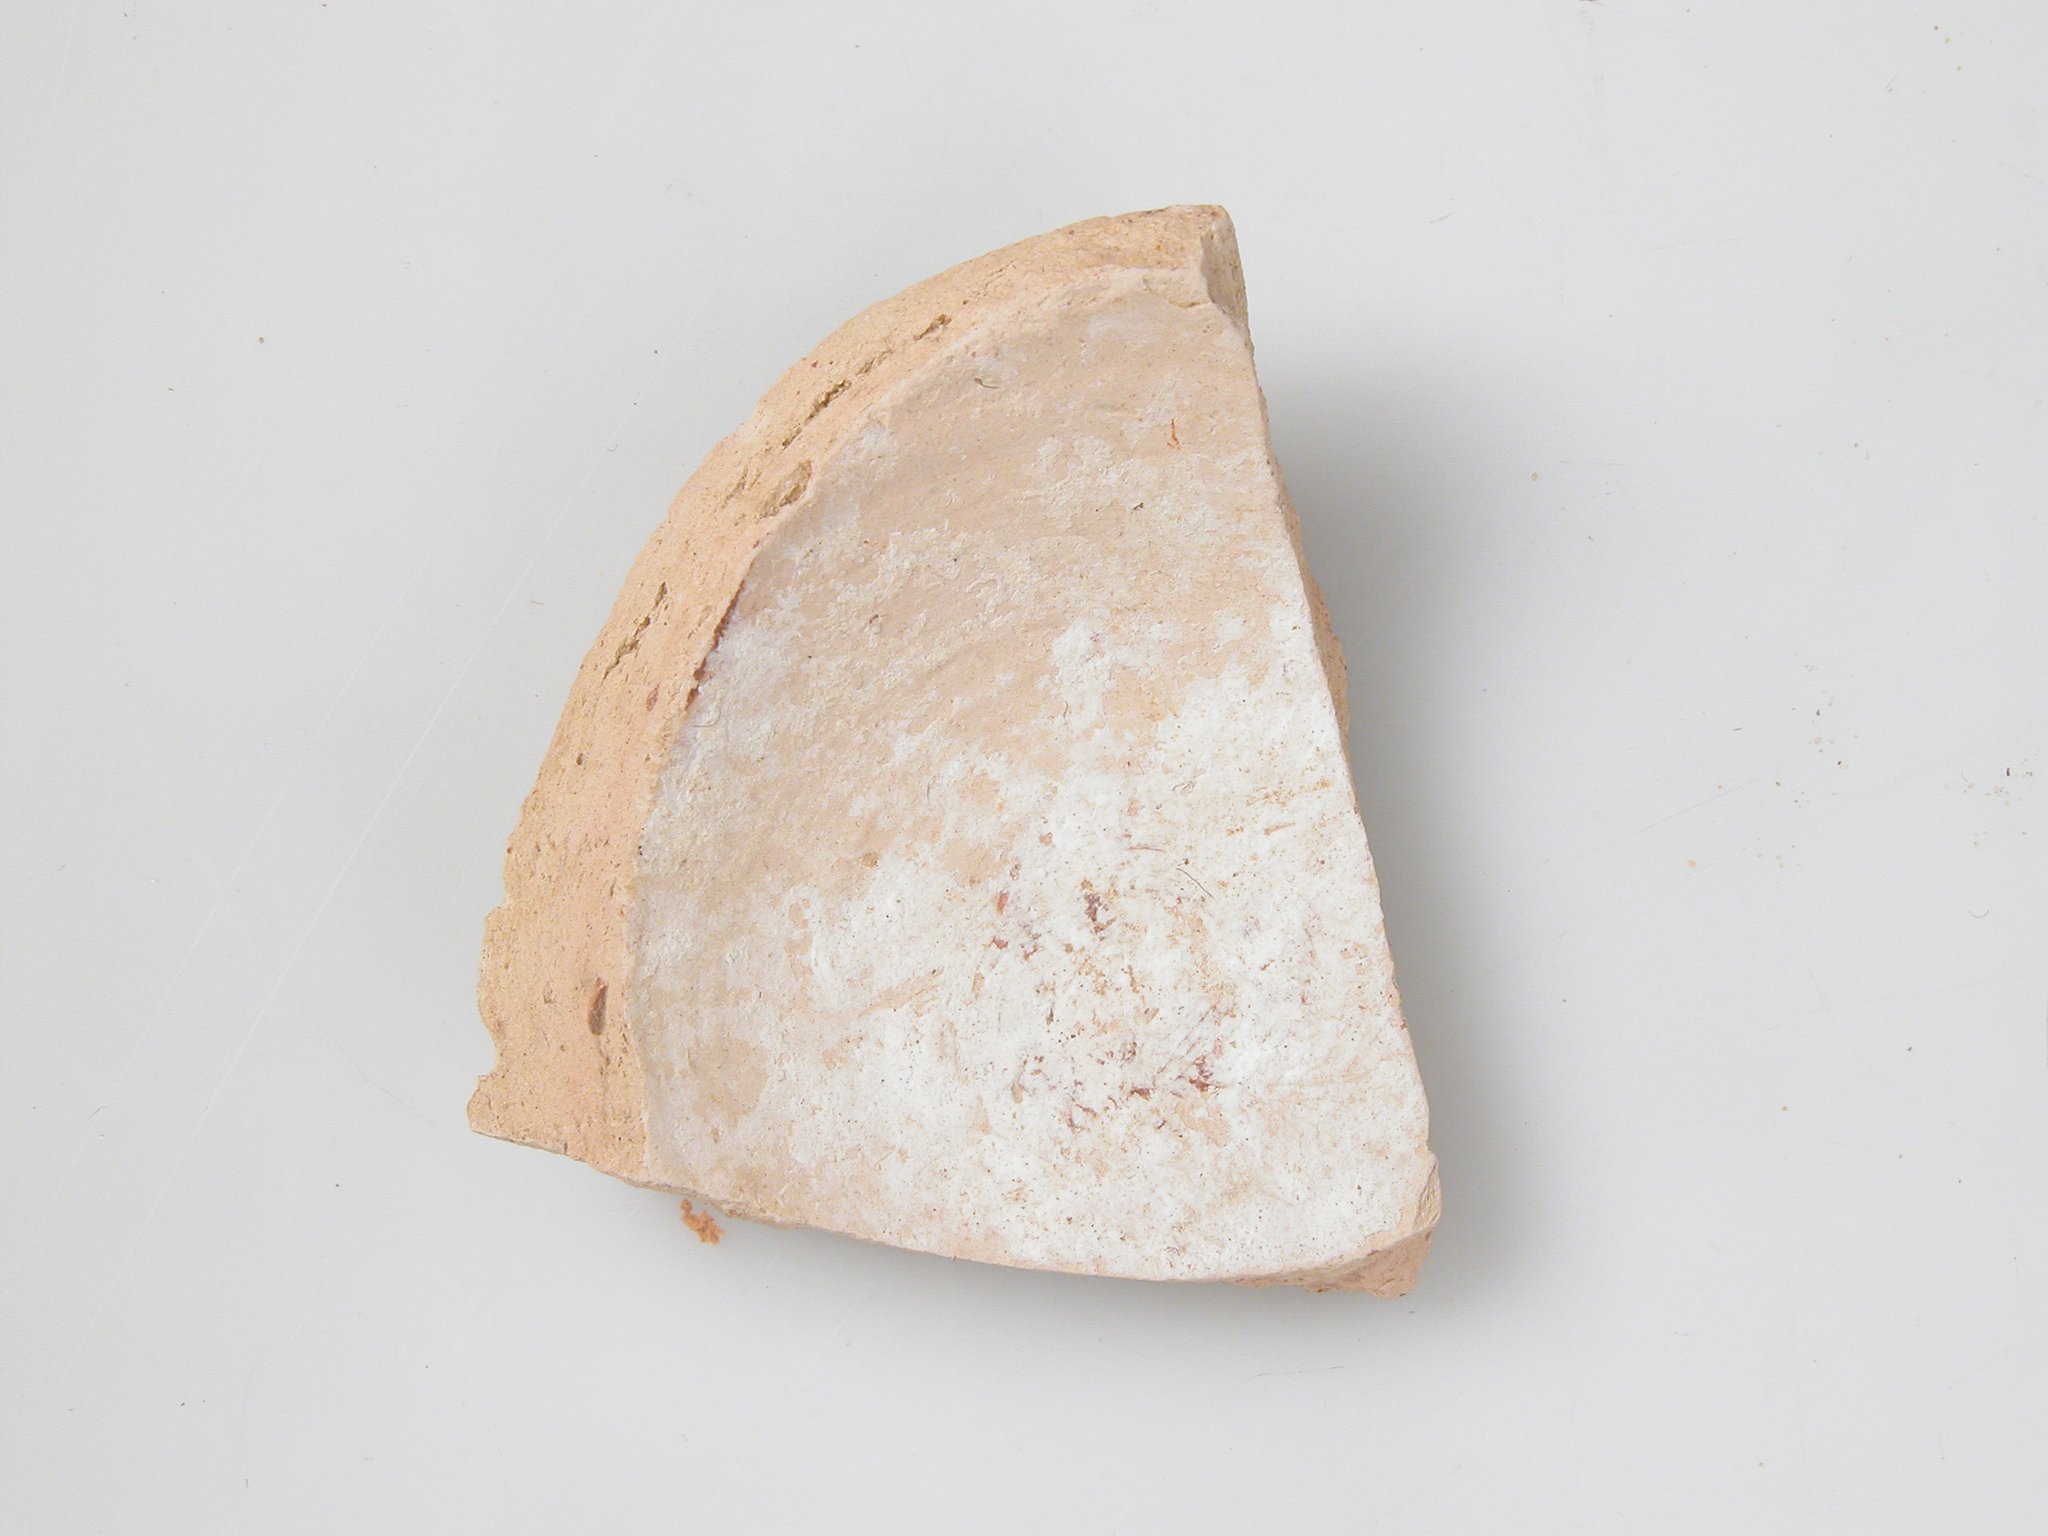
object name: fragment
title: Pottery Fragment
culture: coptic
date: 301-700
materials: earthenware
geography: egypt